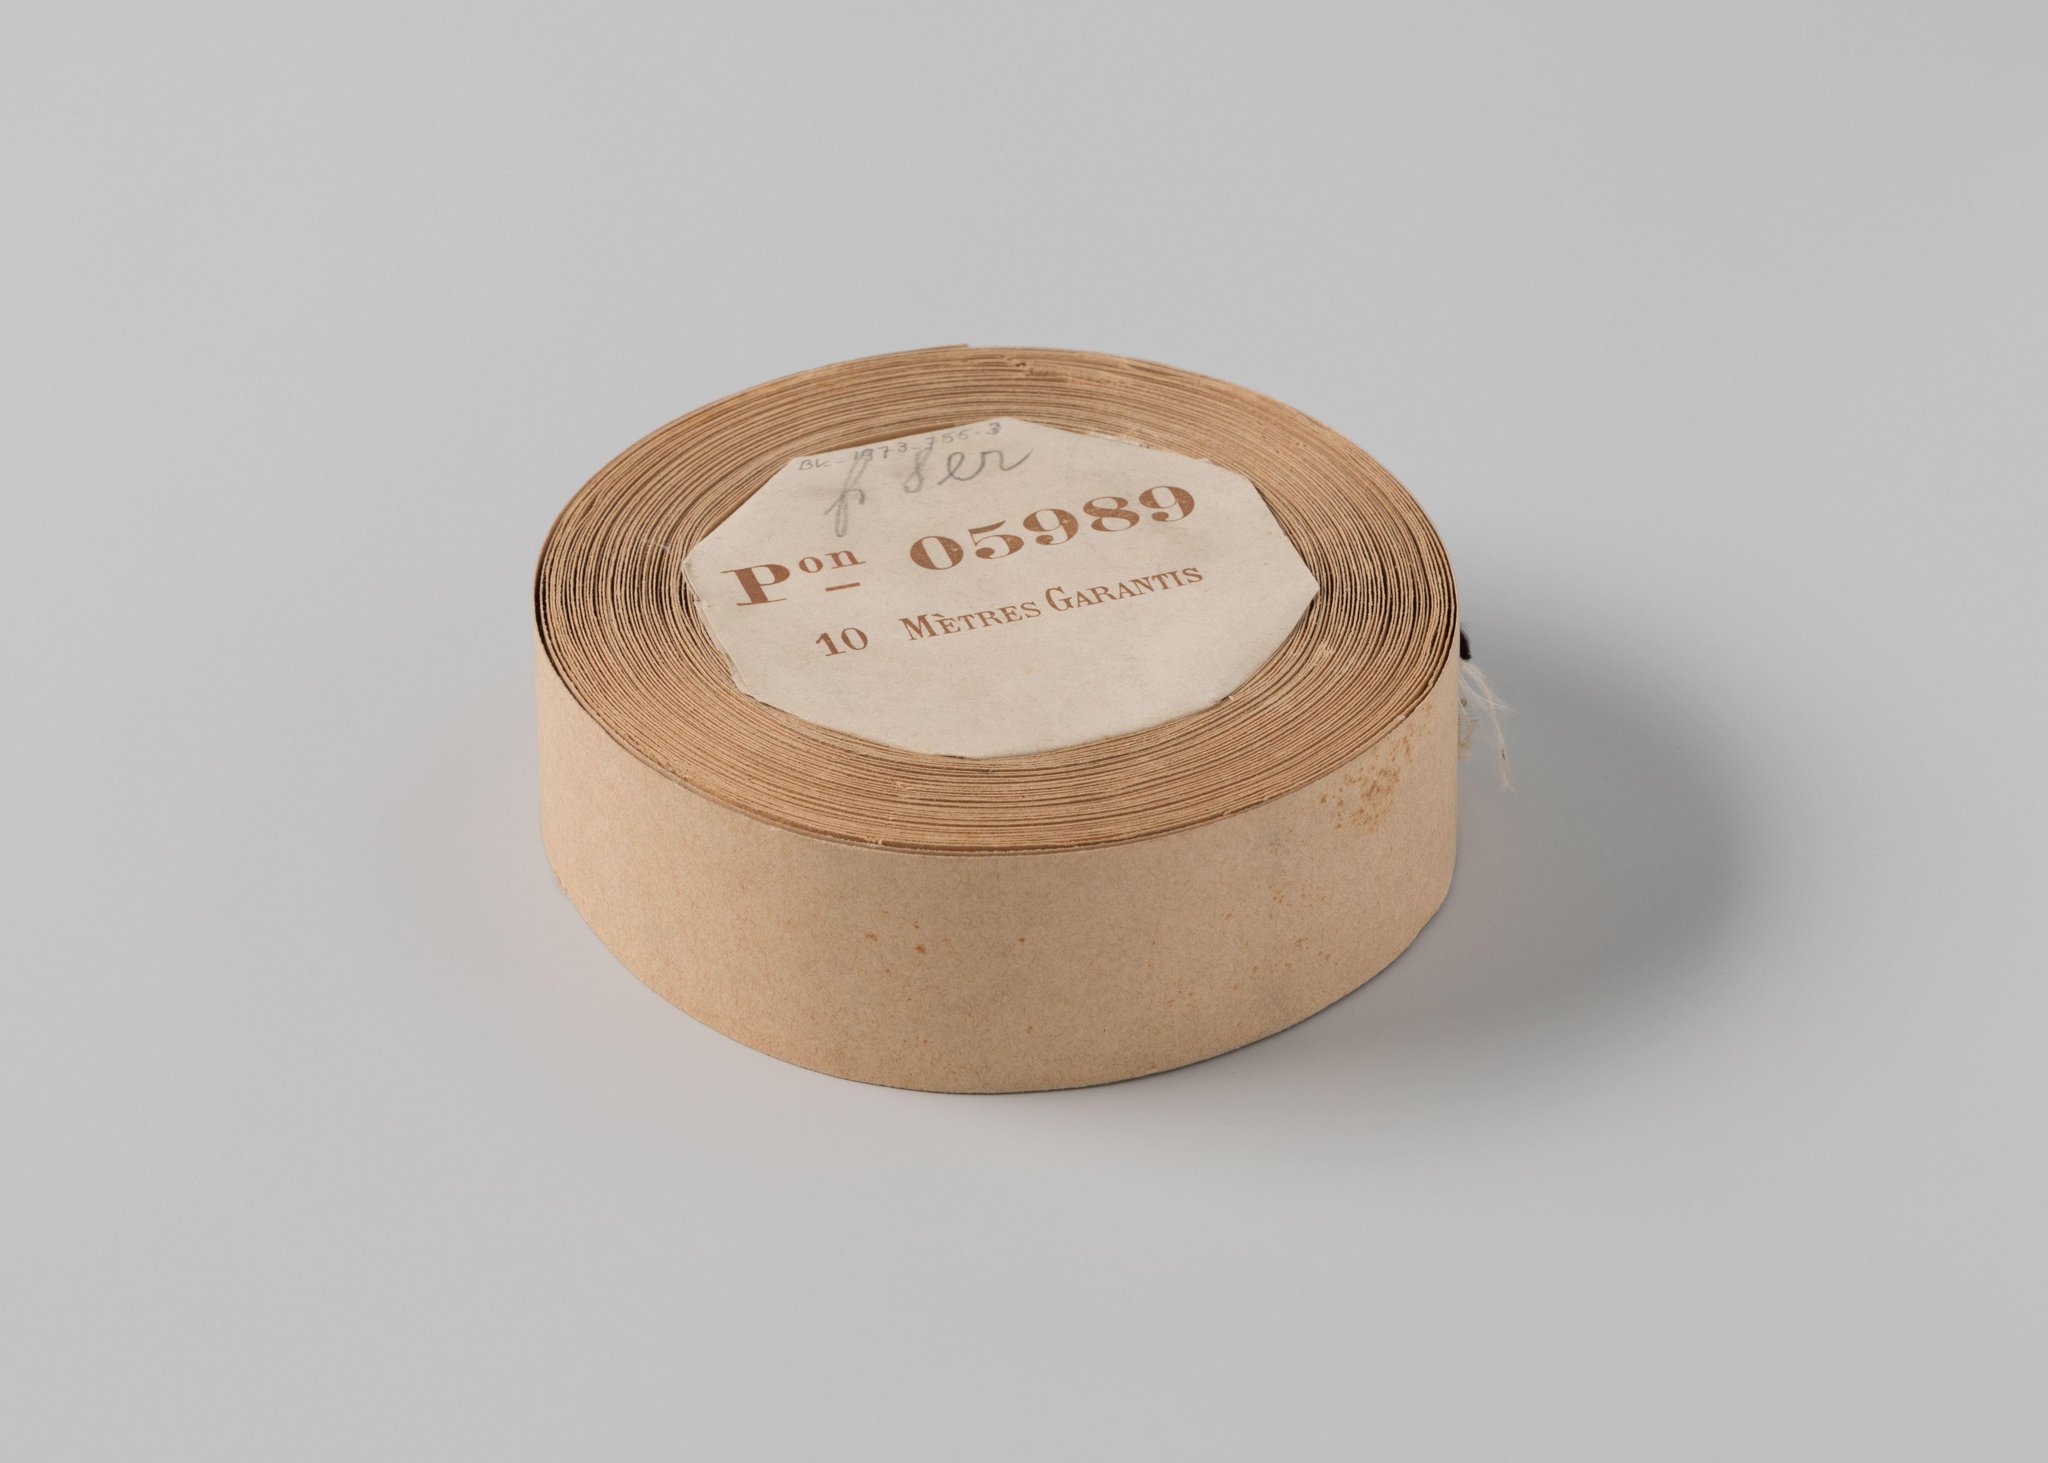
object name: braid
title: Lint op rol, wit satijn aan één kant glad en aan de andere zijde afgezet met een zwarte golvende rand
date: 1890-1935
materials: cardboard, paper, textile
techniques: weave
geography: nijmegen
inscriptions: number: ‘Pon 05989’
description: Lint op rol, wit satijn aan één kant glad en aan de andere zijde afgezet met een zwarte golvende rand.